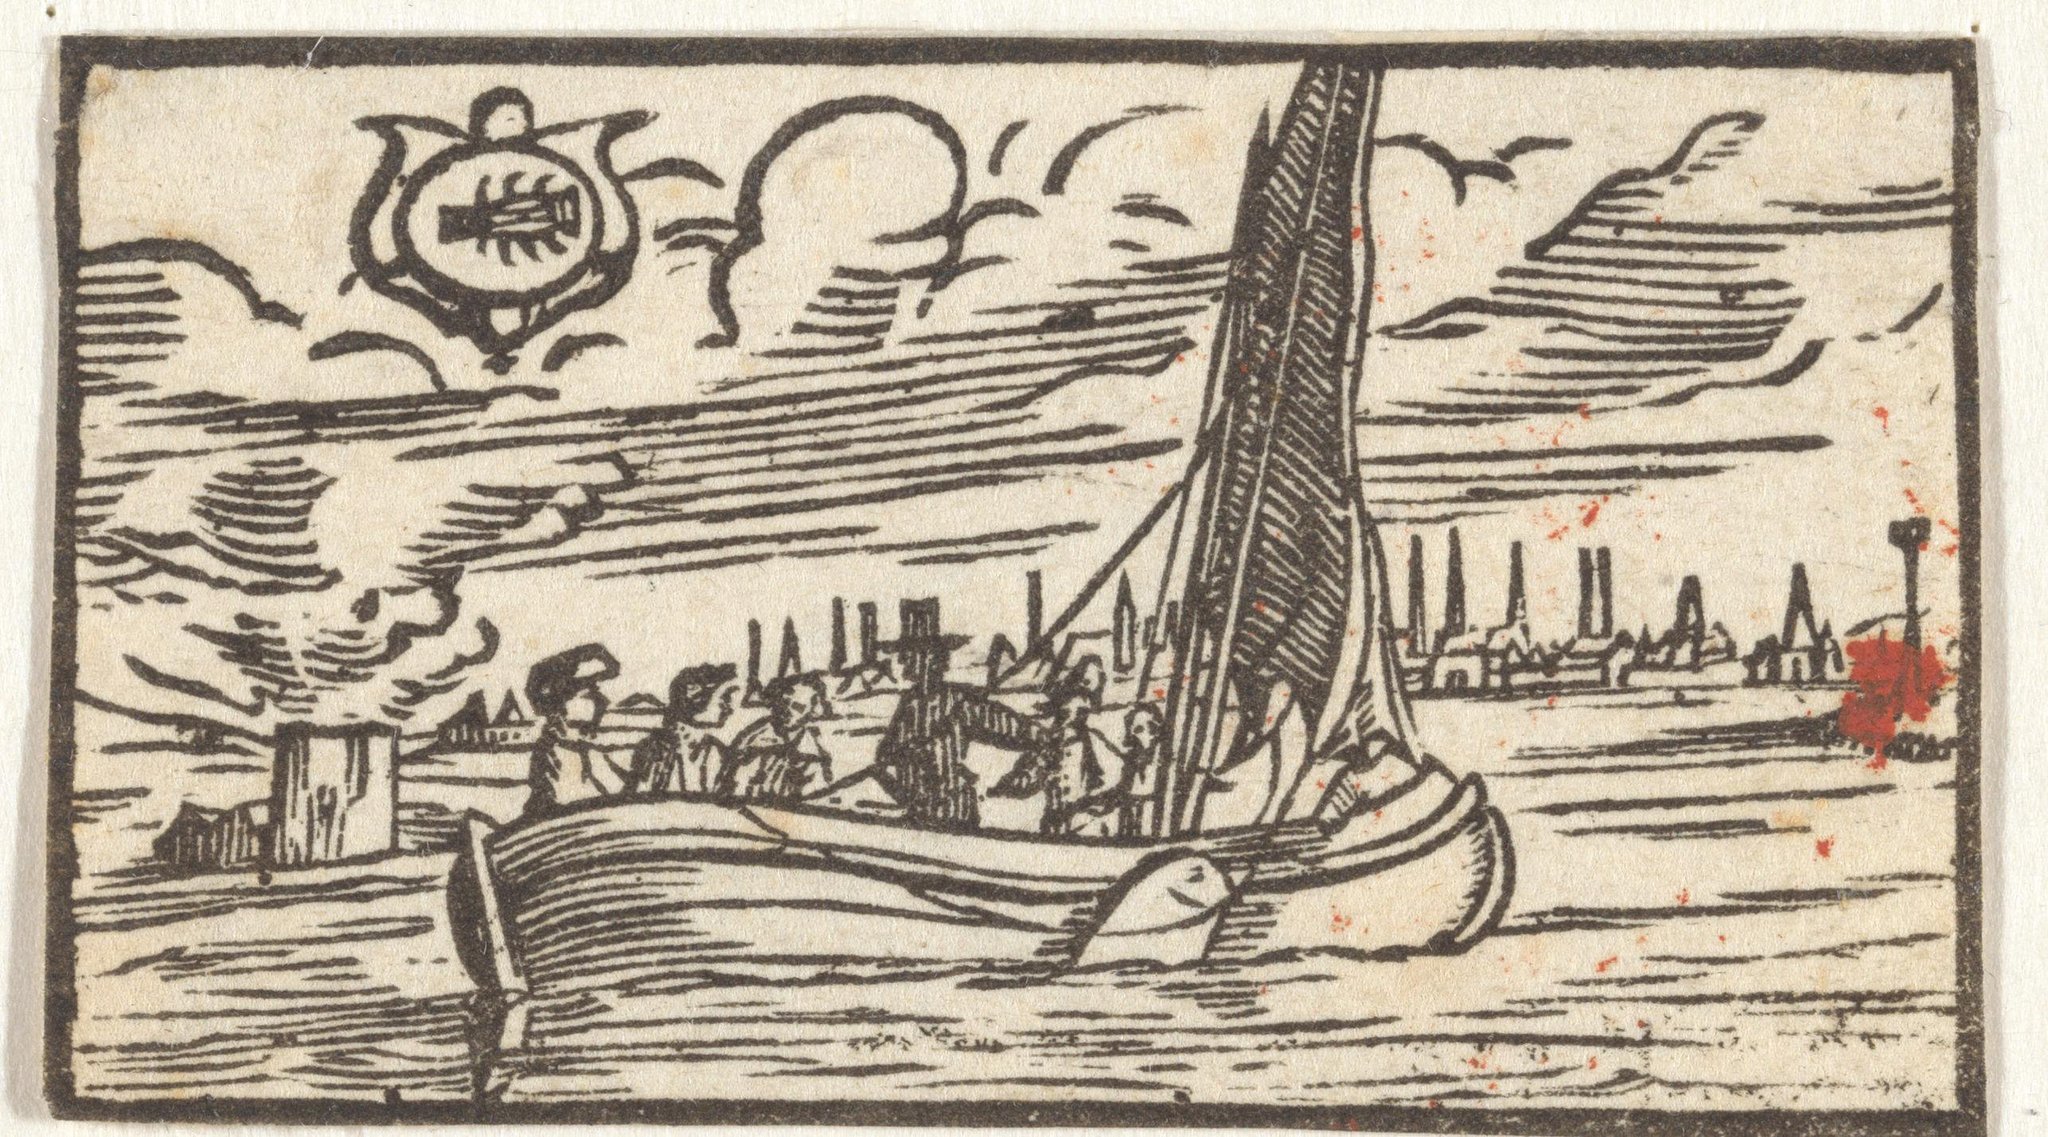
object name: print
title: Maanden van het jaar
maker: Anonymous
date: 1600-1699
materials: paper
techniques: woodcut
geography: netherlands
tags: sailing-ship, sailing-boat, june and its 'labours' (+ with cancer (june))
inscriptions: collector's mark: Lugt 2228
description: Een groep figuren in een zeilboot varend op het water. Linksboven een kreeft.